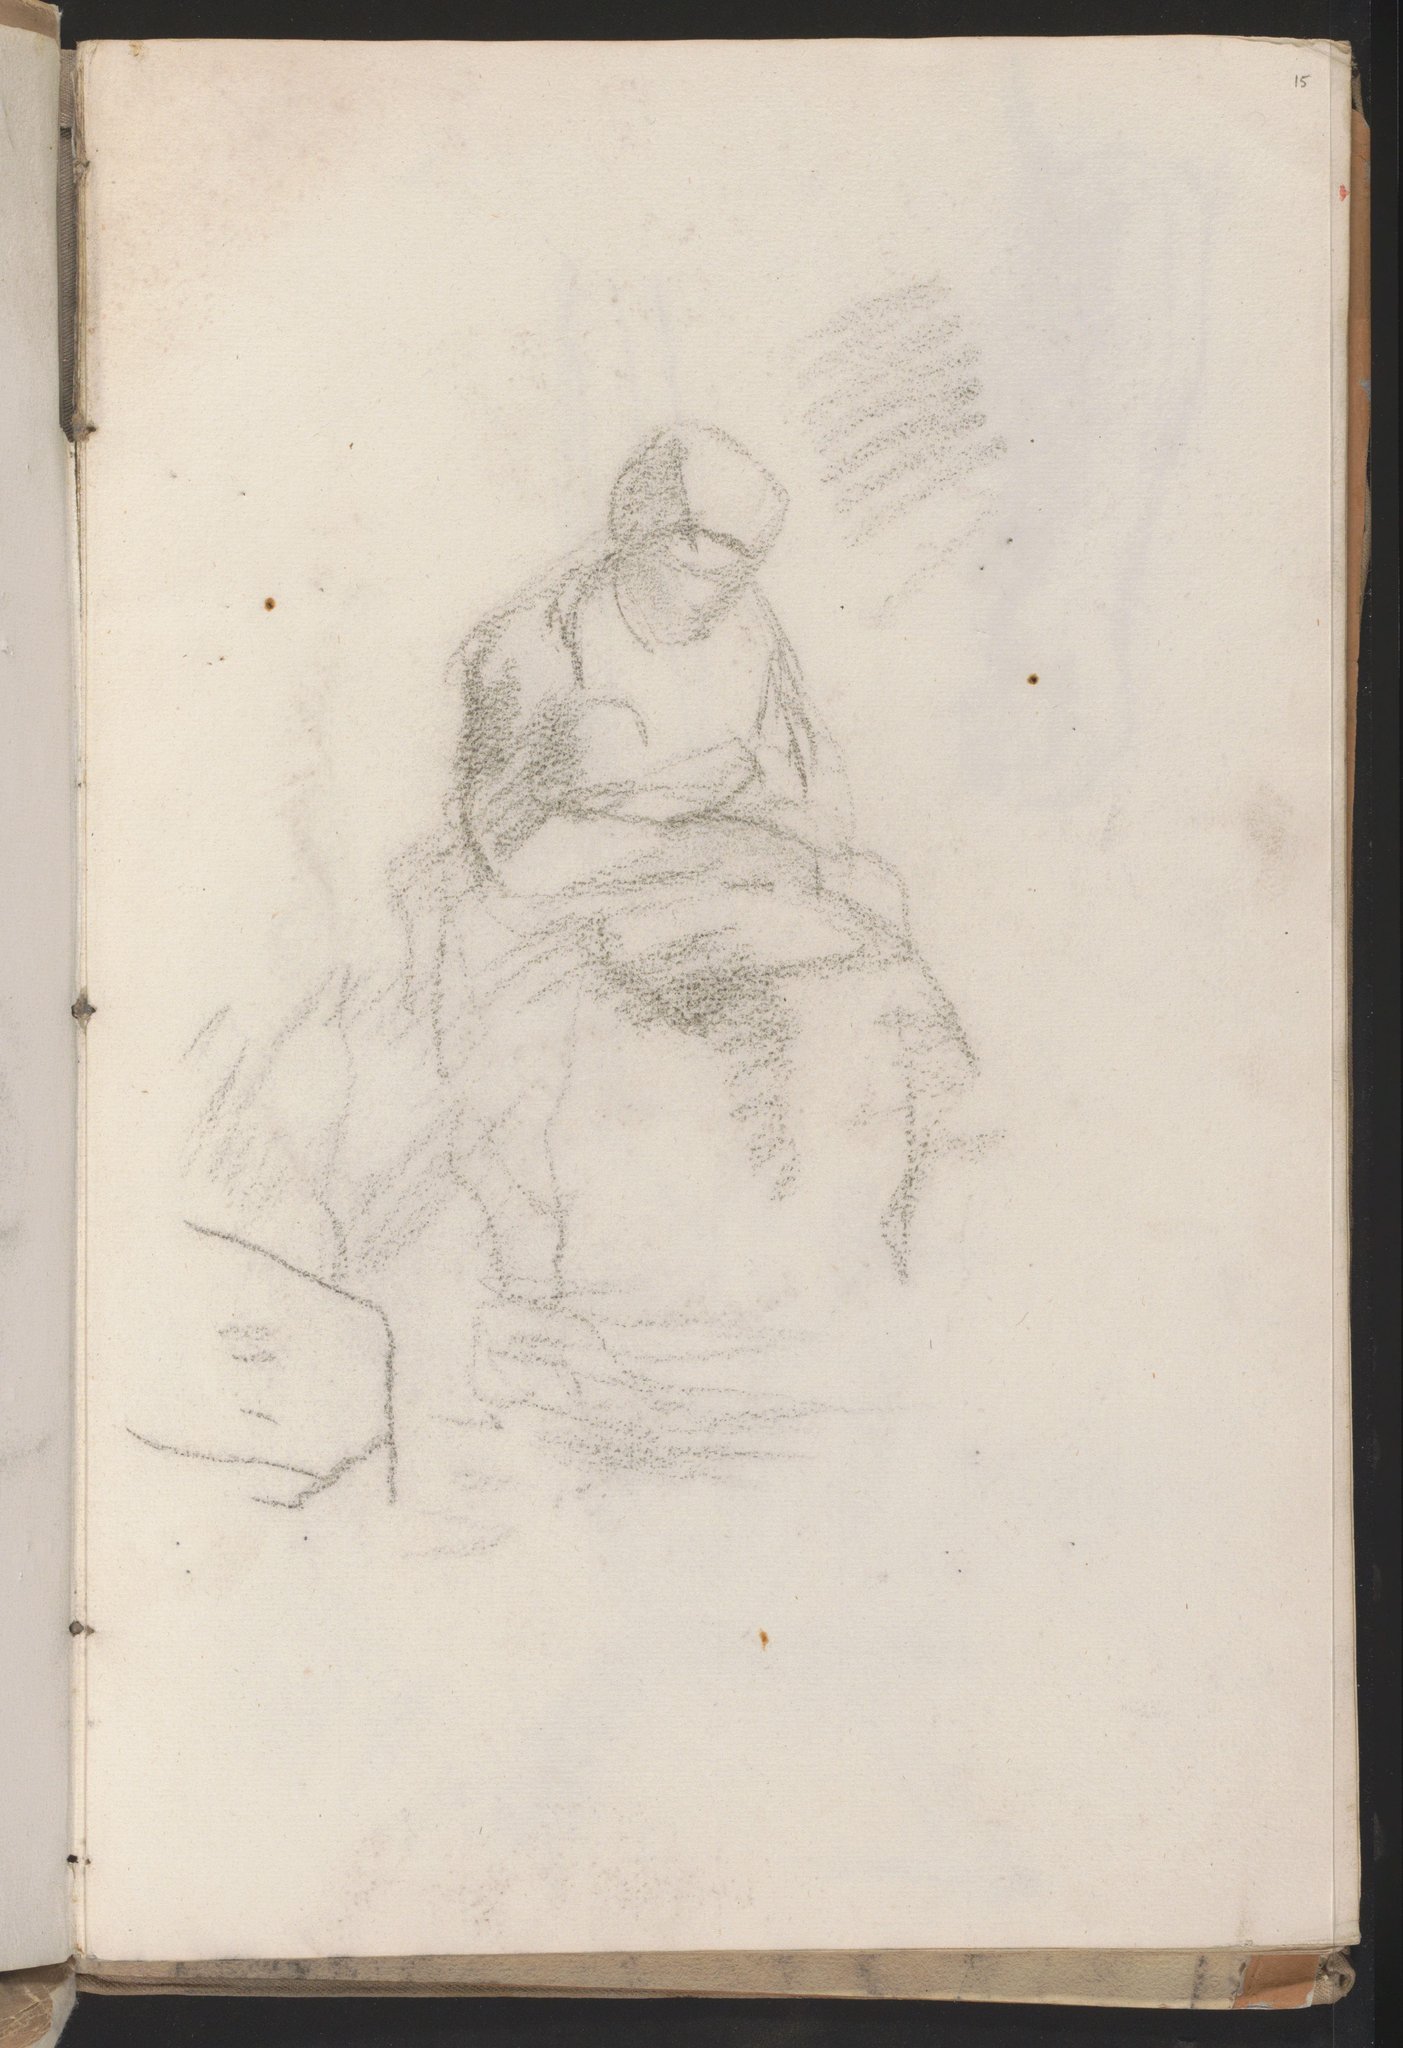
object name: sketchbook leaf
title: Moeder met een baby op de arm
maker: albert neuhuys (1844-1914)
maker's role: draughtsman, painter, print maker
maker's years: 1844-1914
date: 1854-1914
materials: charcoal, paper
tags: mother and baby or young child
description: Blad 15 recto uit een schetsboek met 53 bladen.